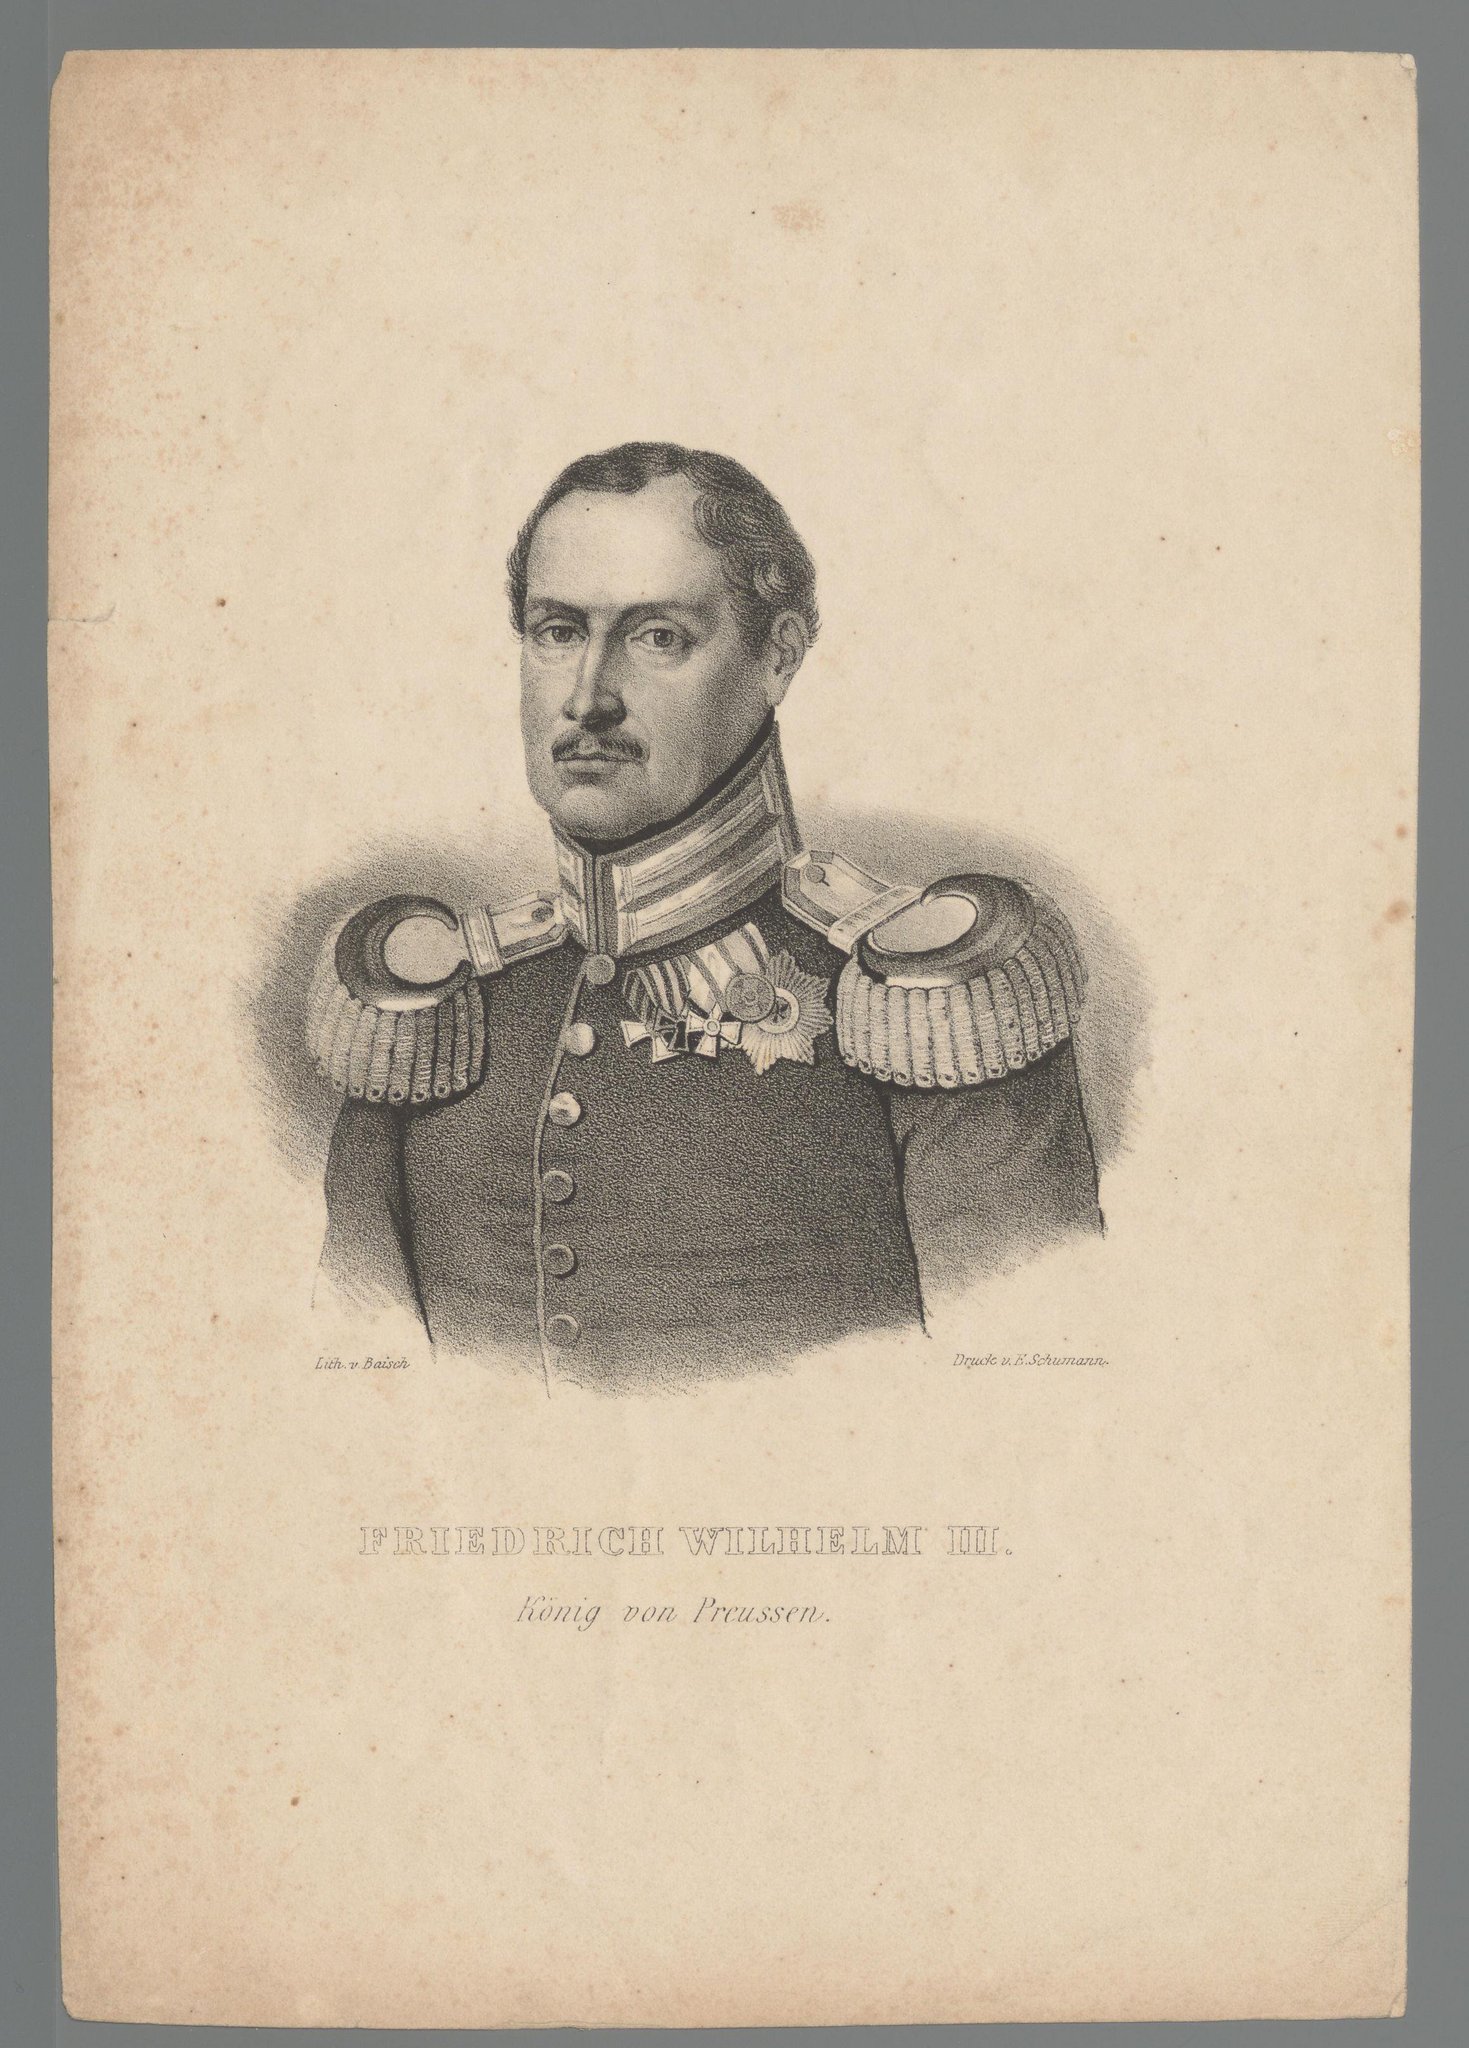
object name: print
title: Friedrich Wilhelm III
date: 1815-1864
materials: paper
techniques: lithograph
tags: berlin, frederik willem iii koning van pruisen, historical persons, king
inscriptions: collector's mark: Lugt 2228